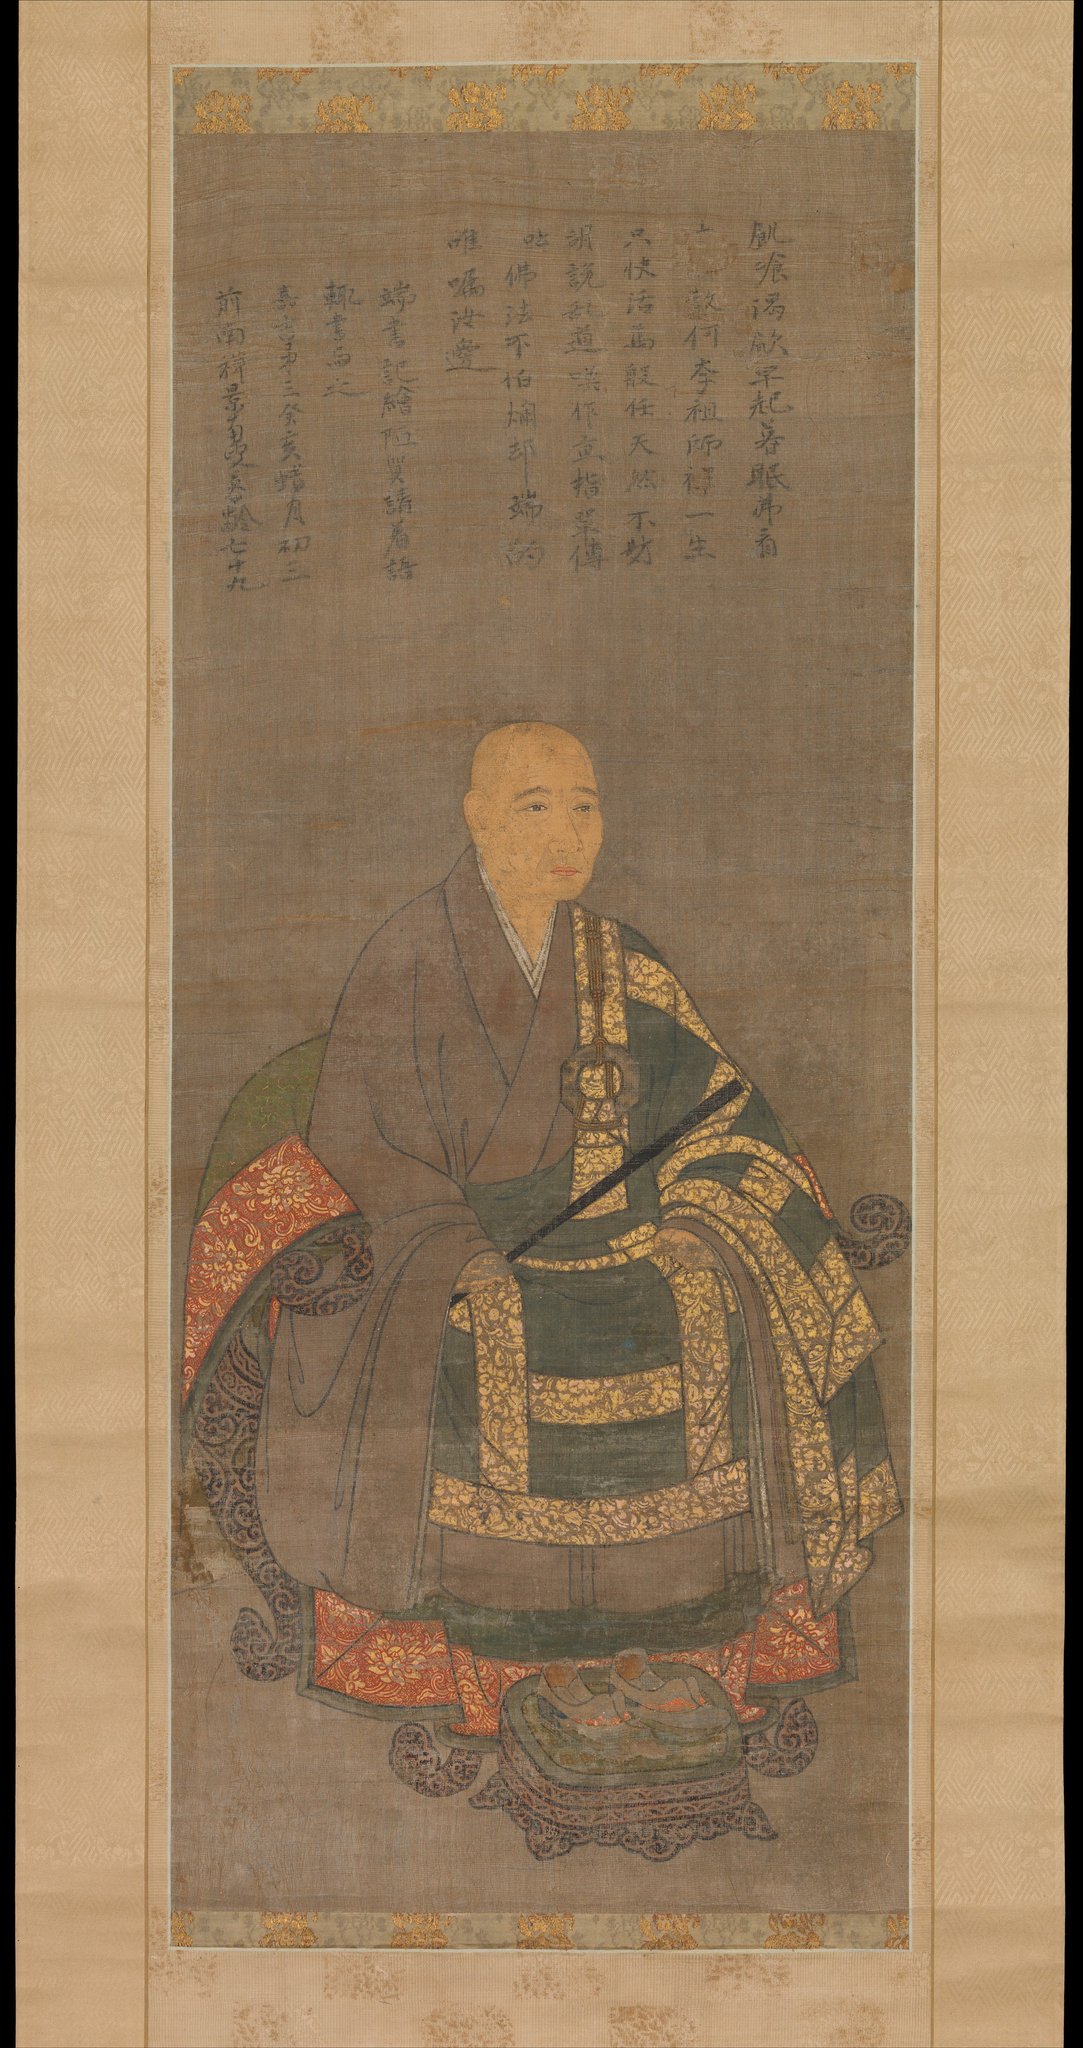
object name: hanging scroll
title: Portrait of Keinan Eibun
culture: japanese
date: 1449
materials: gold, ink, silk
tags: men,portraits